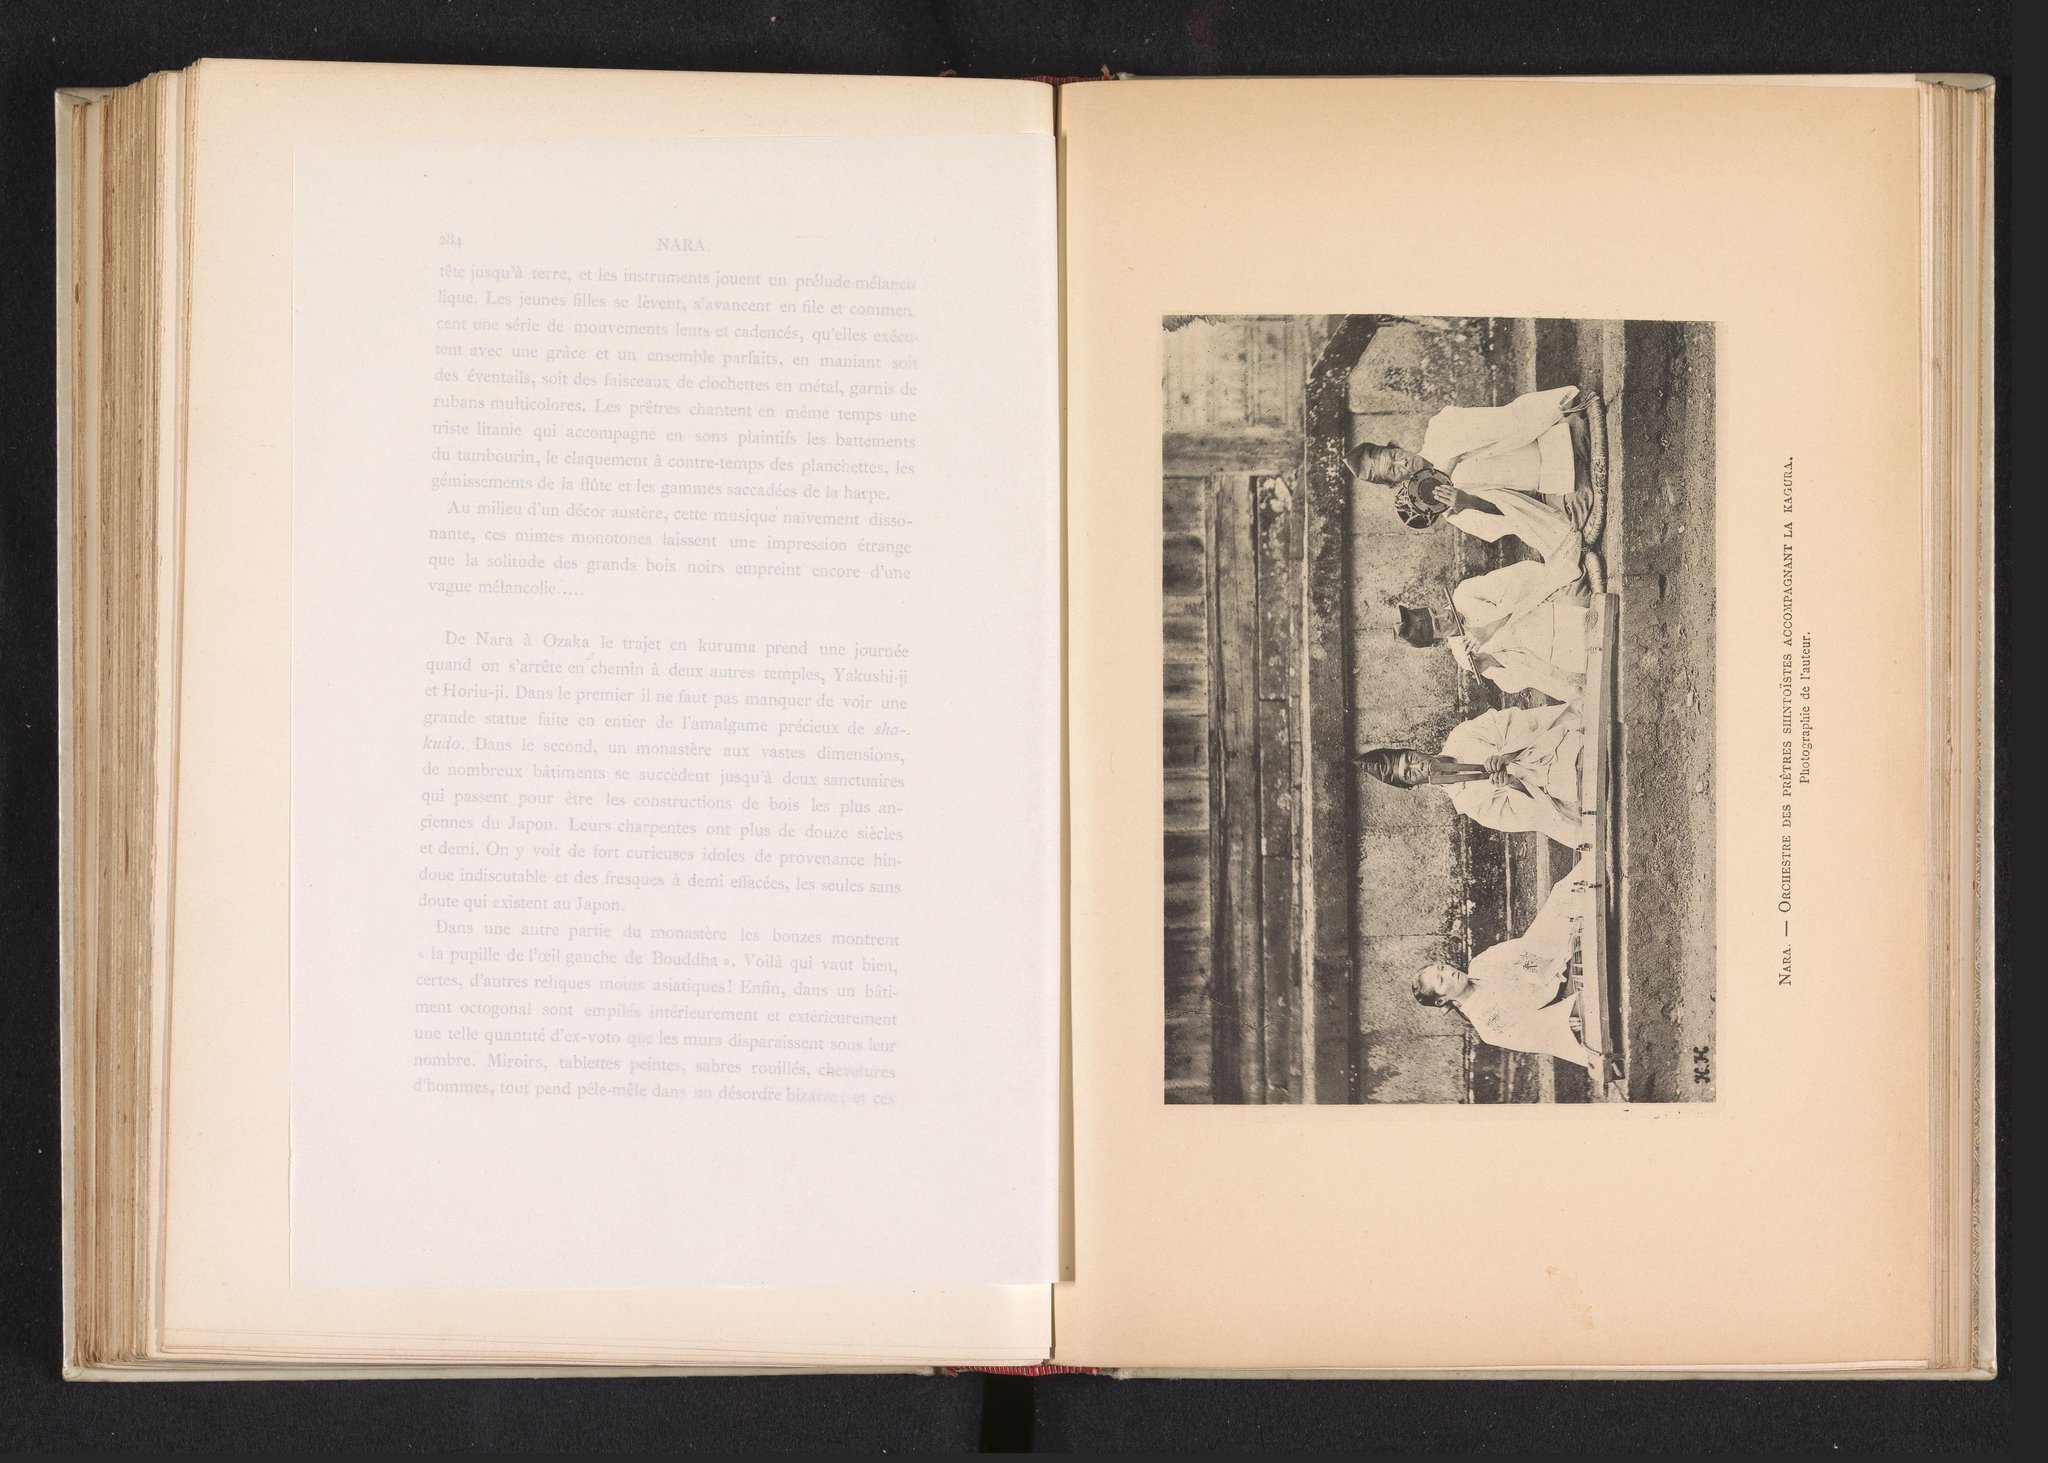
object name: photomechanical print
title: Nara. - Orchestre des prêtres siintoïstes accompagnant la kagura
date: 1882-1883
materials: paper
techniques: photograph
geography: nara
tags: musical instruments; group of musical instruments, priest ~ shinto, shinto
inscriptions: inscription: ‘H. K.’, inscription: ‘Photographie de l'auteur.’